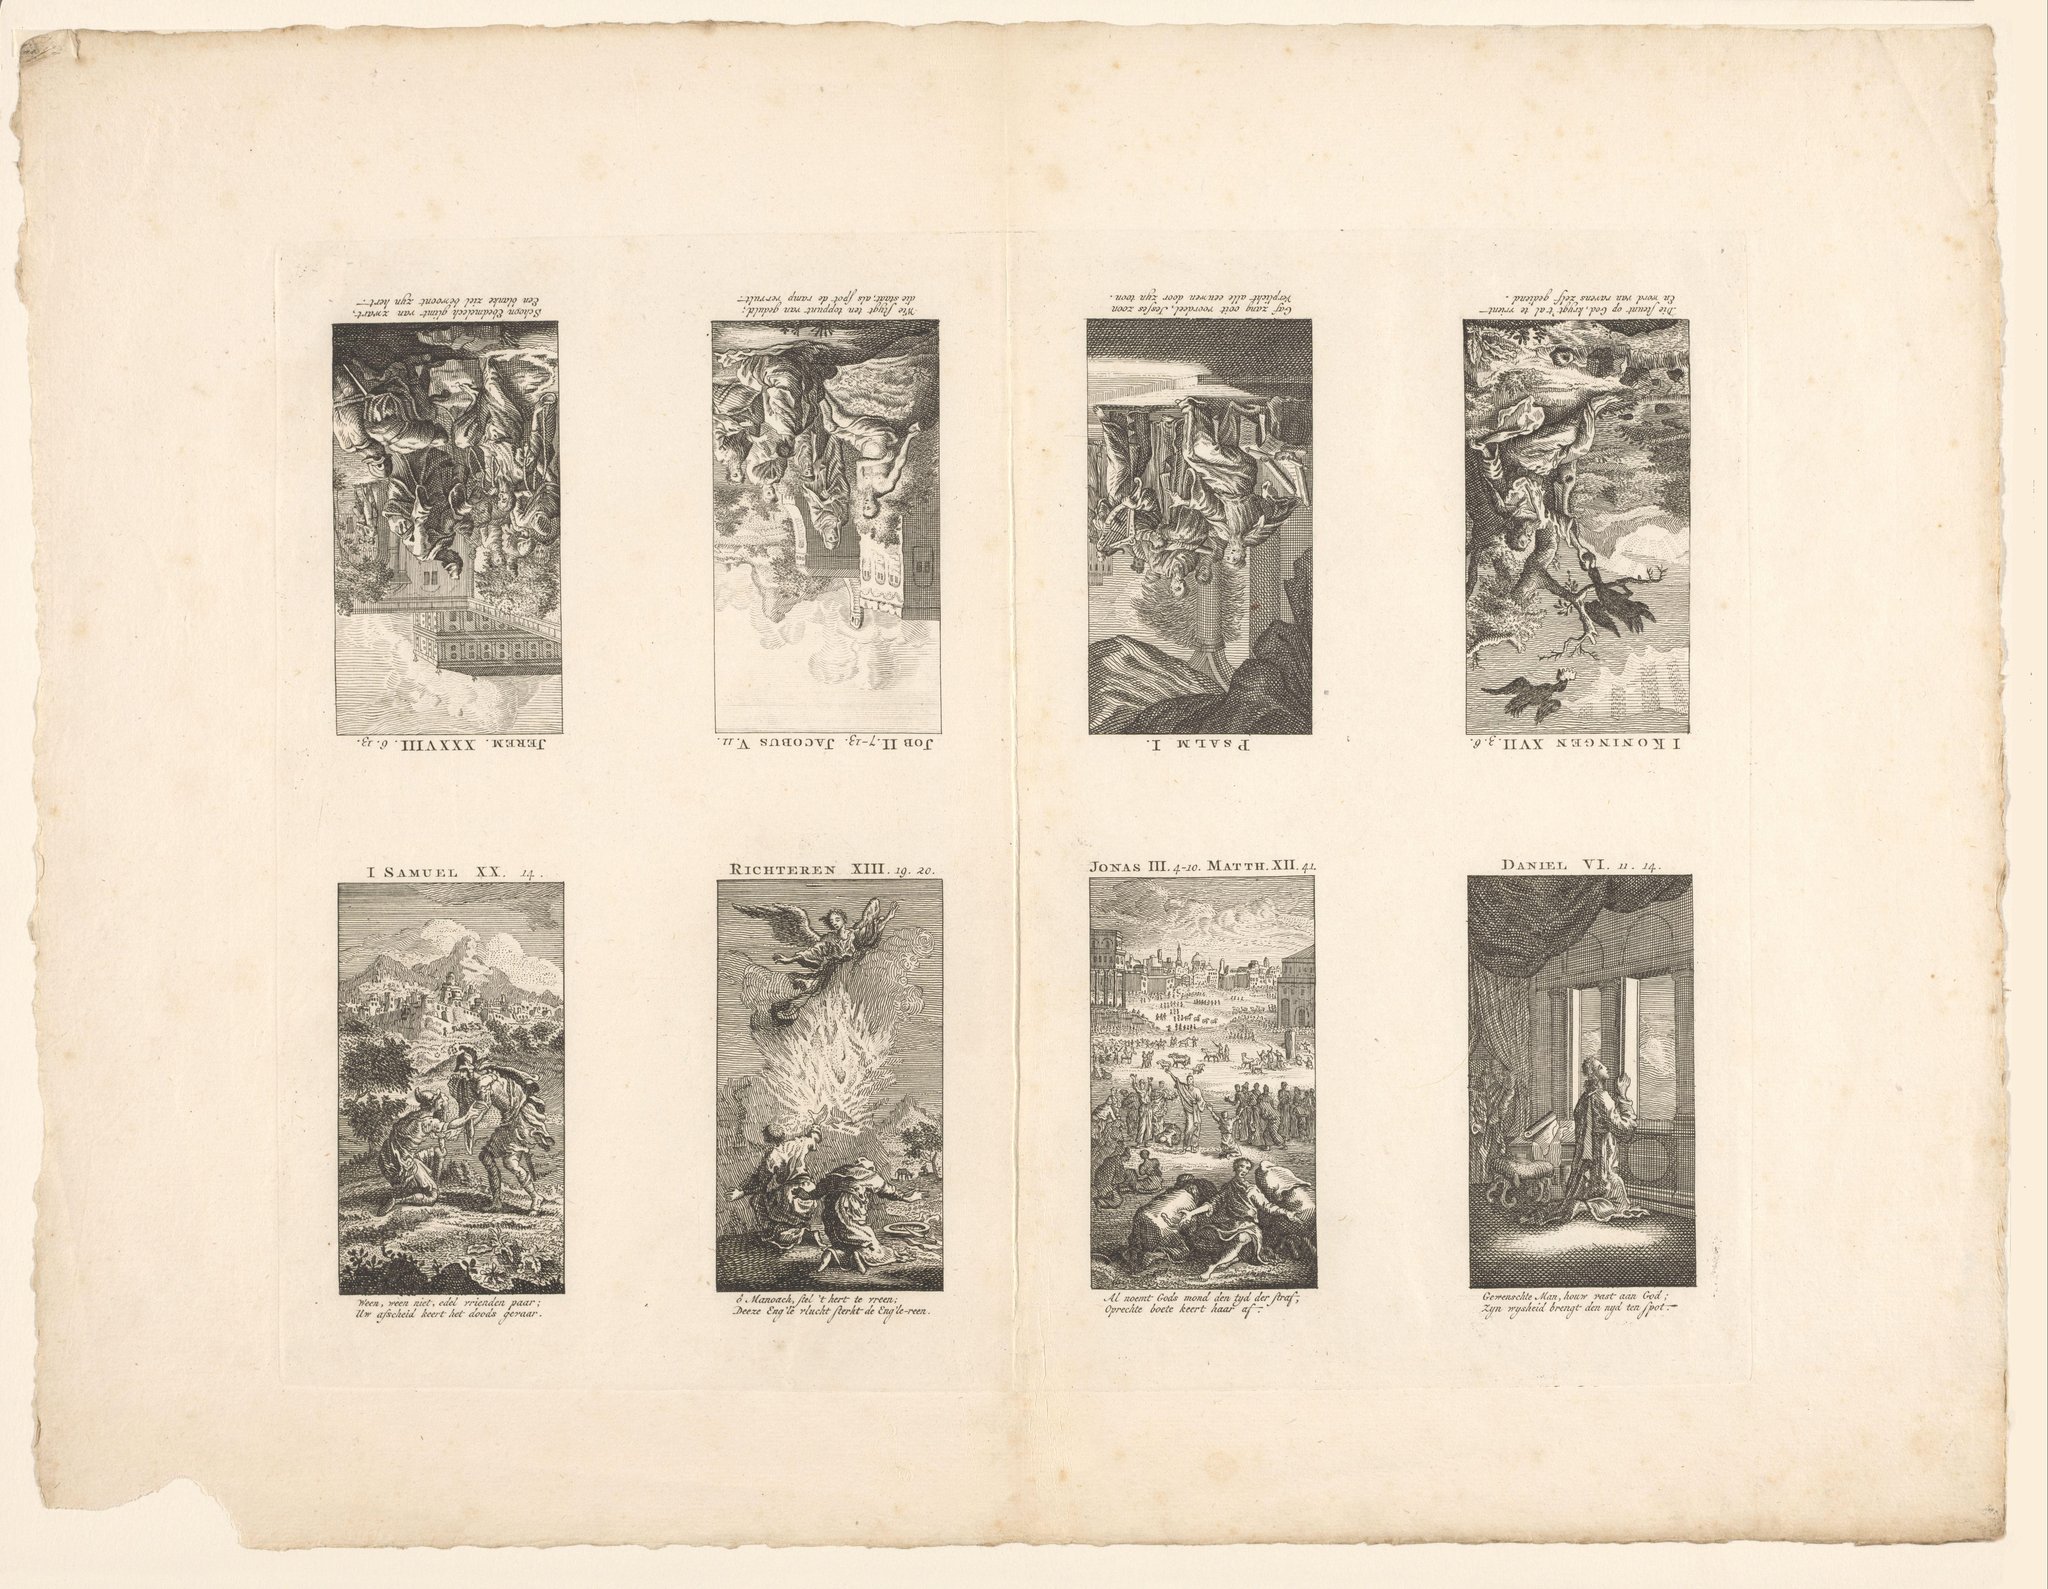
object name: print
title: Acht bijbelvoorstellingen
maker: Anonymous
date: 1720-1790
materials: paper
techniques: etching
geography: amsterdam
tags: jeremiah is released from the dungeon, david and jonathan embracing; david's leave-taking from jonathan, david as psalmist, as author of the psalms, usually playing the harp, eliphaz, bildad and zophar silently sit on the ground with job for seven days, elijah fed by the raven(s): while the prophet is living by the brook, ravens bring him food, daniel, while praying on his knees before an open window, is discovered by the conspirators, manoah's sacrifice; the angel ascends in the flames, when the king of nineveh hears about the destruction of the city in forty days, he rises from his throne and decrees a general repentance for man and animal: all men, cattle and sheep must fast, people must wear sackcloth and pray to god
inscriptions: collector's mark: Lugt 2228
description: Zeer vergelijkbare prenten (dezelfde composities met minimale verschillen) zijn in verscheidene achttiende-eeuwse boeken gebruikt, zoals in: Biblia, dat is De gantsche Heilige Schrift (...). Amsterdam: Anthony en Hendrik Bruyn, 1734. En in: Entrop, Pieter Jan. De kerkelyke en Joodsche geschiedenissen verkort (...). Amsterdam: Pieter Jan Entrop, 1762. Of in de editie van 1780. De publicatie waar de hier beschreven prenten voor zijn bedoeld is niet gevonden.